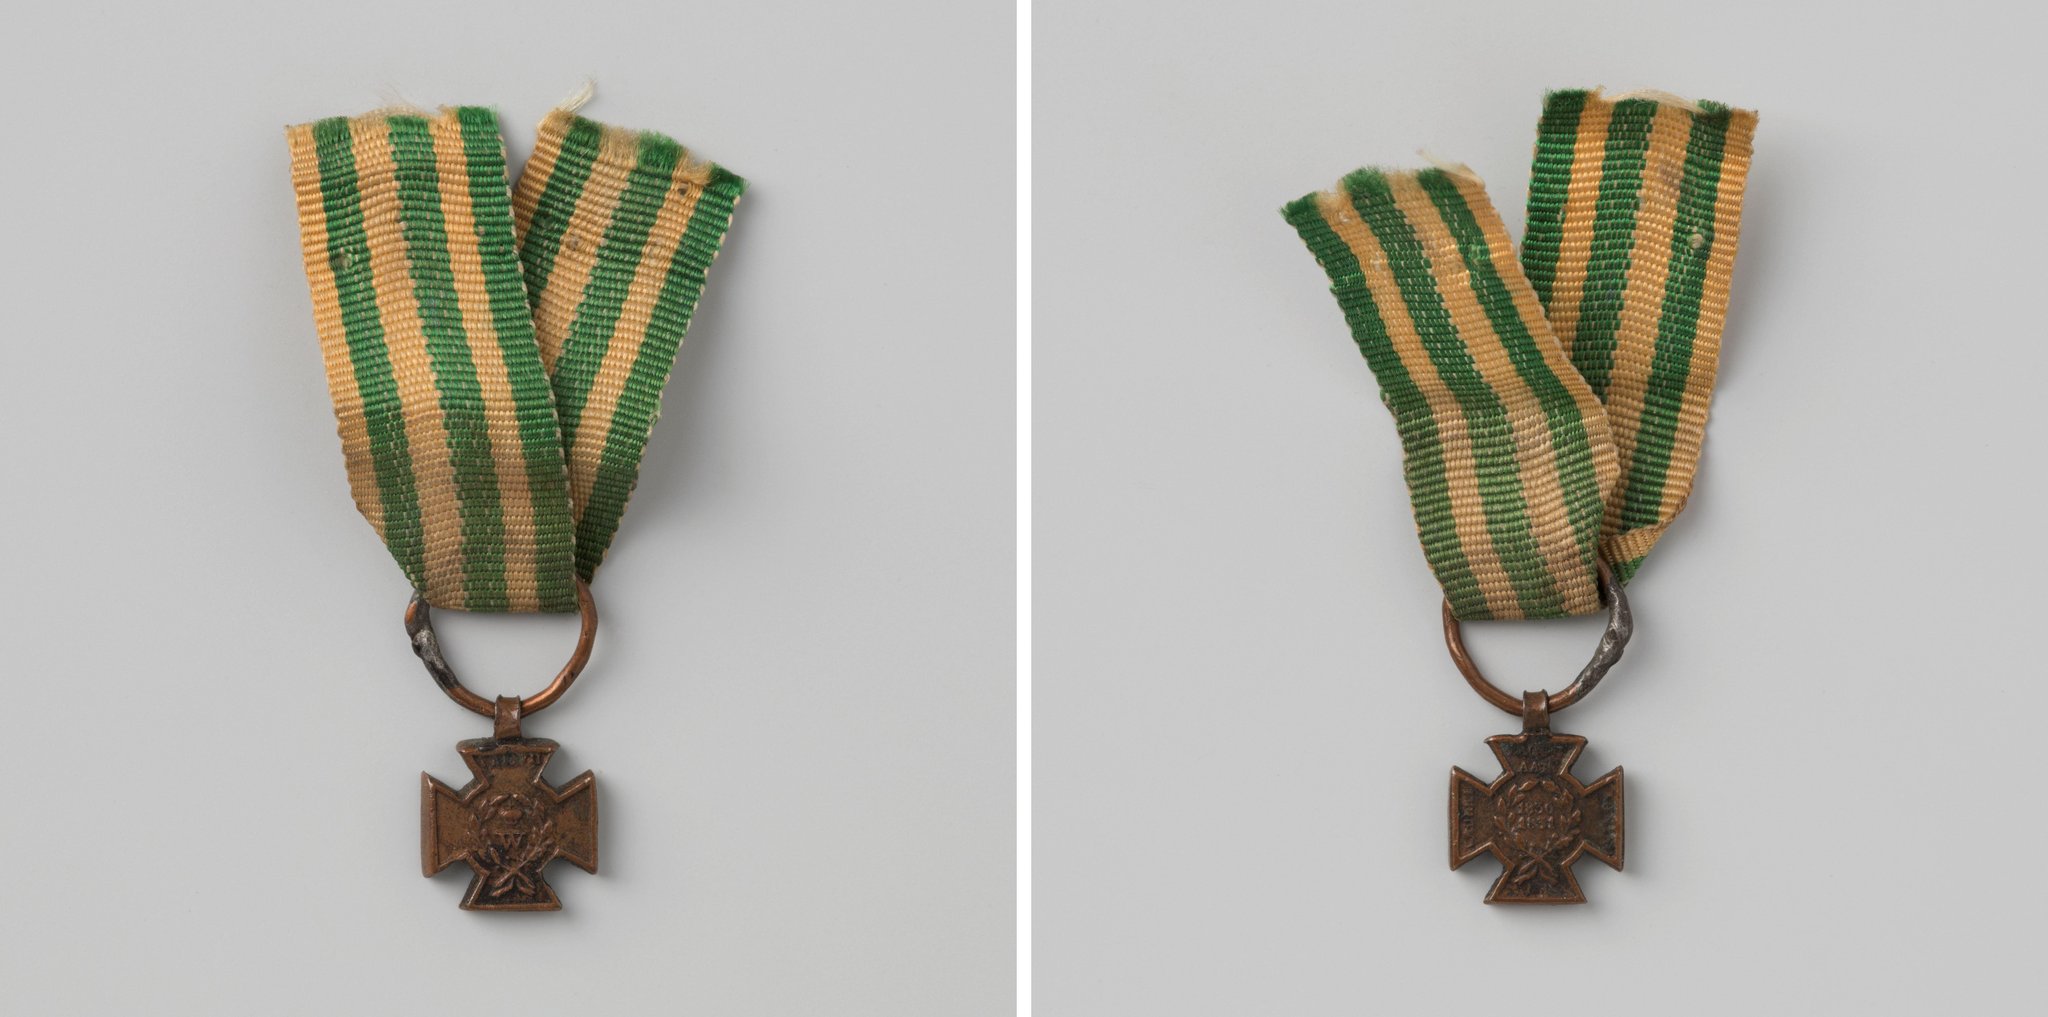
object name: history medal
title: Metalen Kruis voor vrijwilligers, miniatuur 8 mm, 1831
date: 1831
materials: bronze, textile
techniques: striking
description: Bronzen kruis met oog en draagring aan een groen-geel gestreept lint, op de voorzijde een gekroonde letter W tussen samengestrikte lauwertakken, op het bovenste been VRIJVII, op de keerzijde 1830-1831 tussen samengestrikte eiken- en lauwertakken, op de benen TROUW AAN - KONING - EN - VADERL